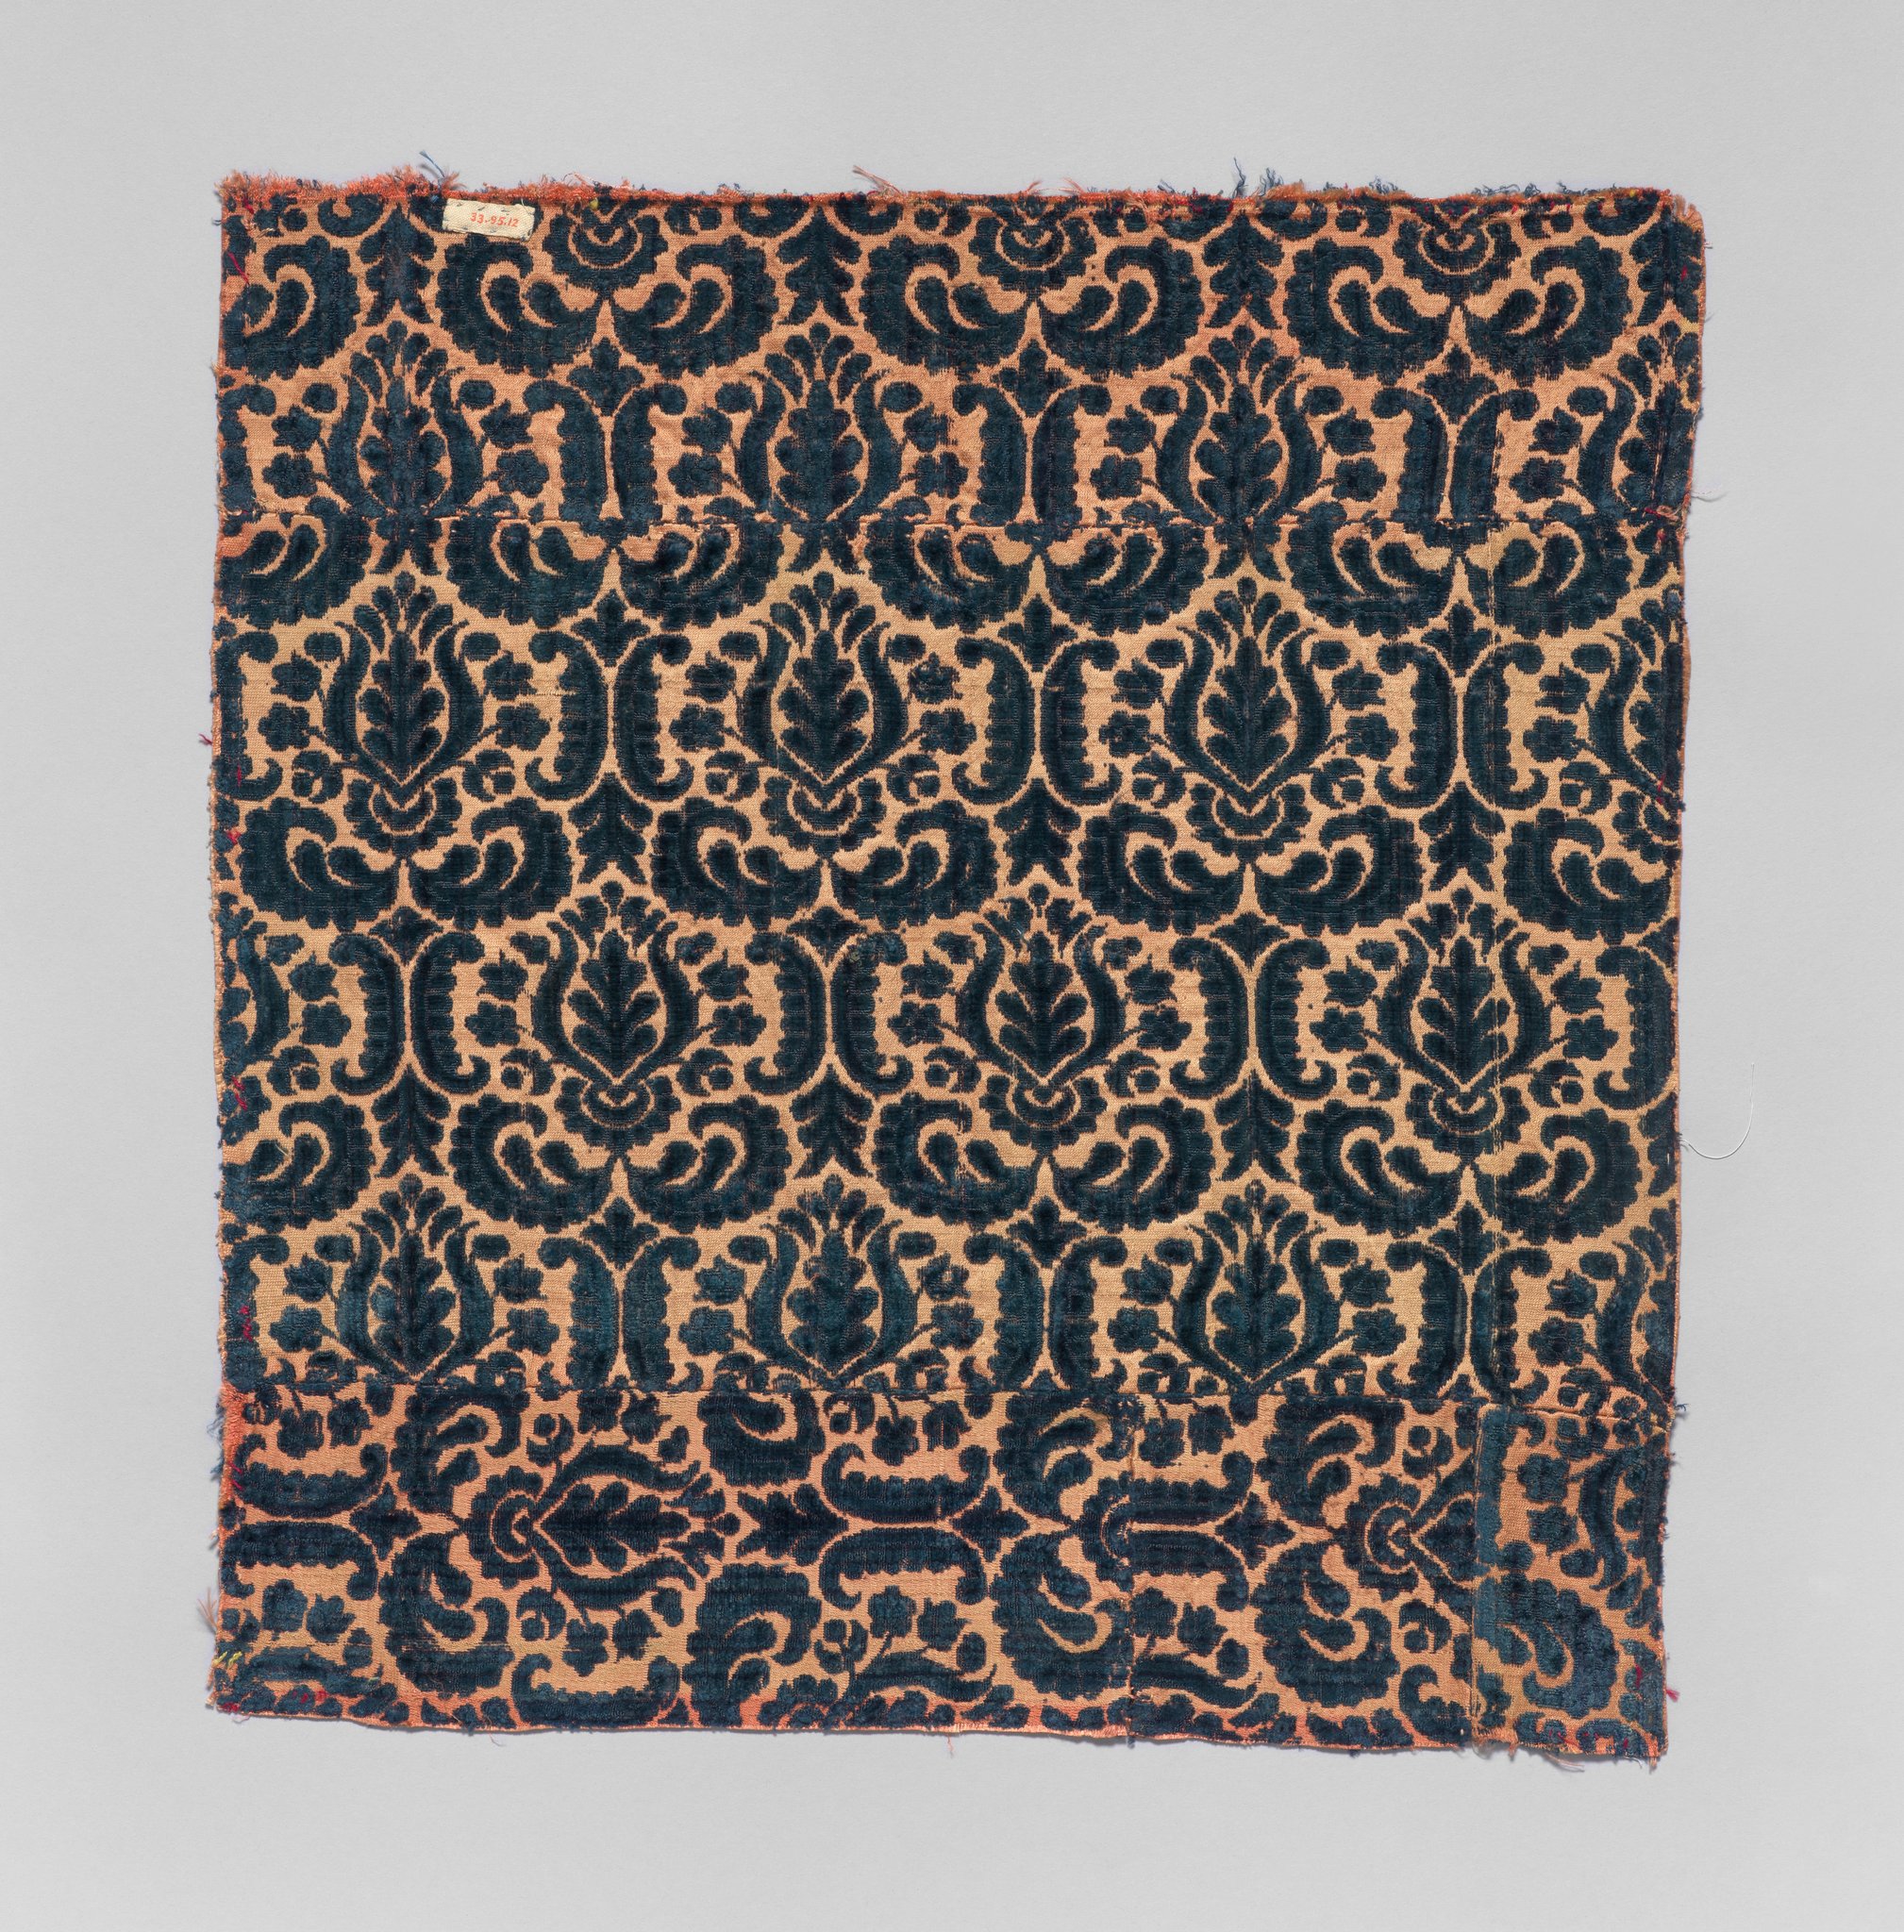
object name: piece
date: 1567-1600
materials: silk